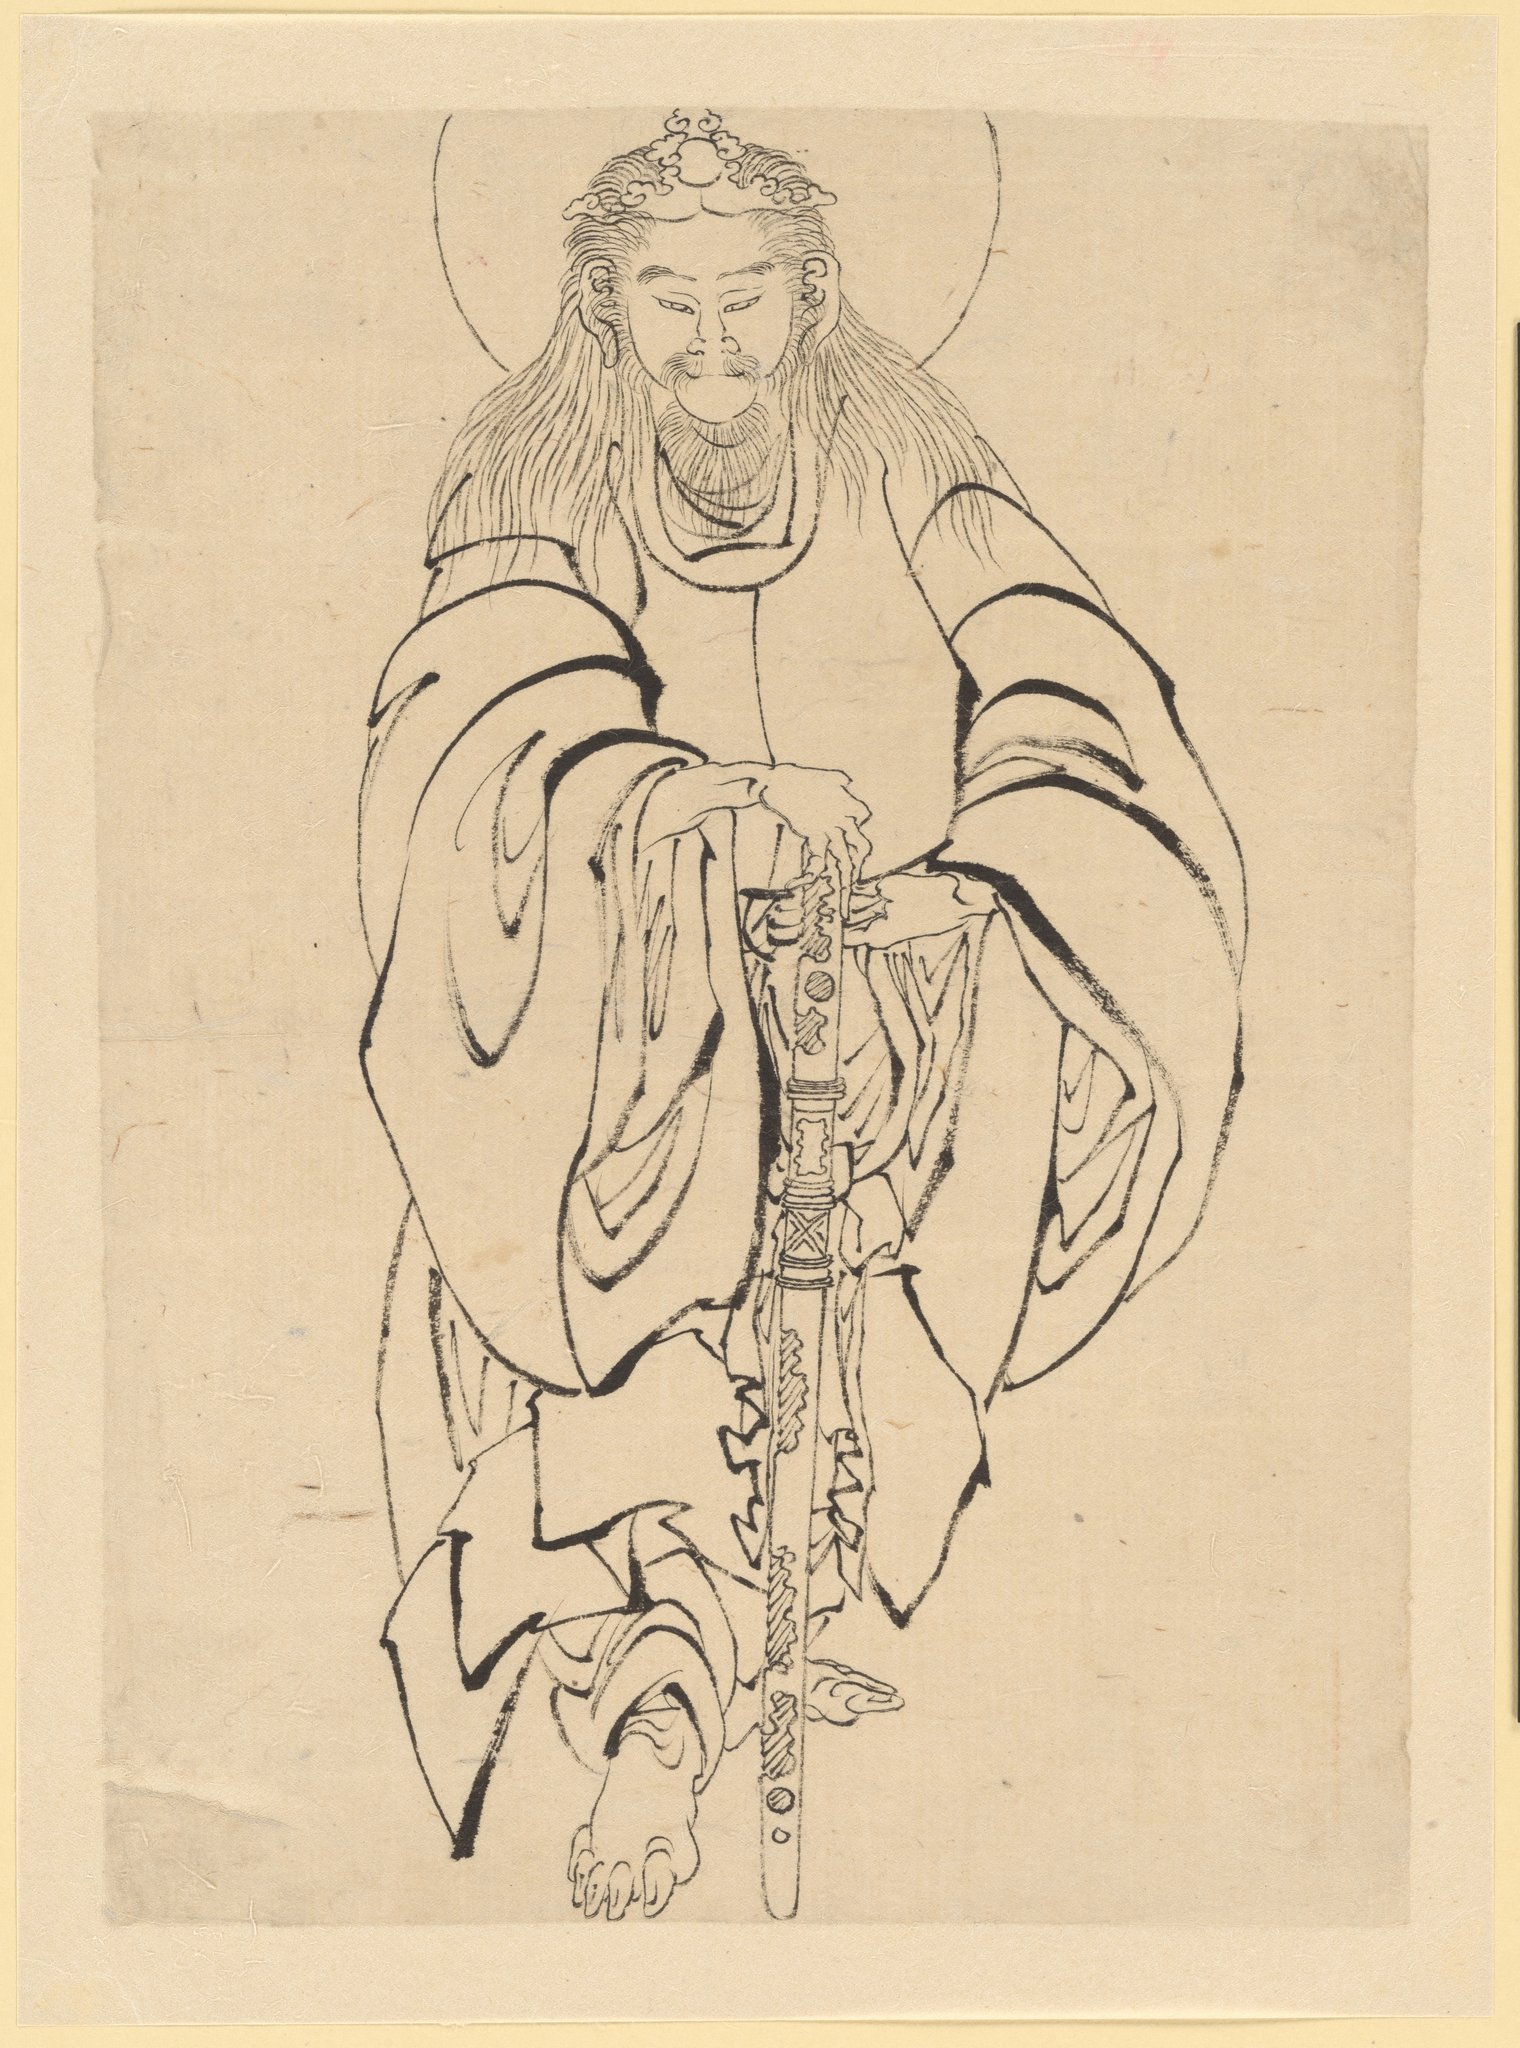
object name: drawing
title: Yamato Takeru no Mikoto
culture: japanese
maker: katsushika hokusai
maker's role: artist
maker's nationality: japanese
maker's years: 1760-1849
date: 1701-1900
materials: ink, paper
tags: men